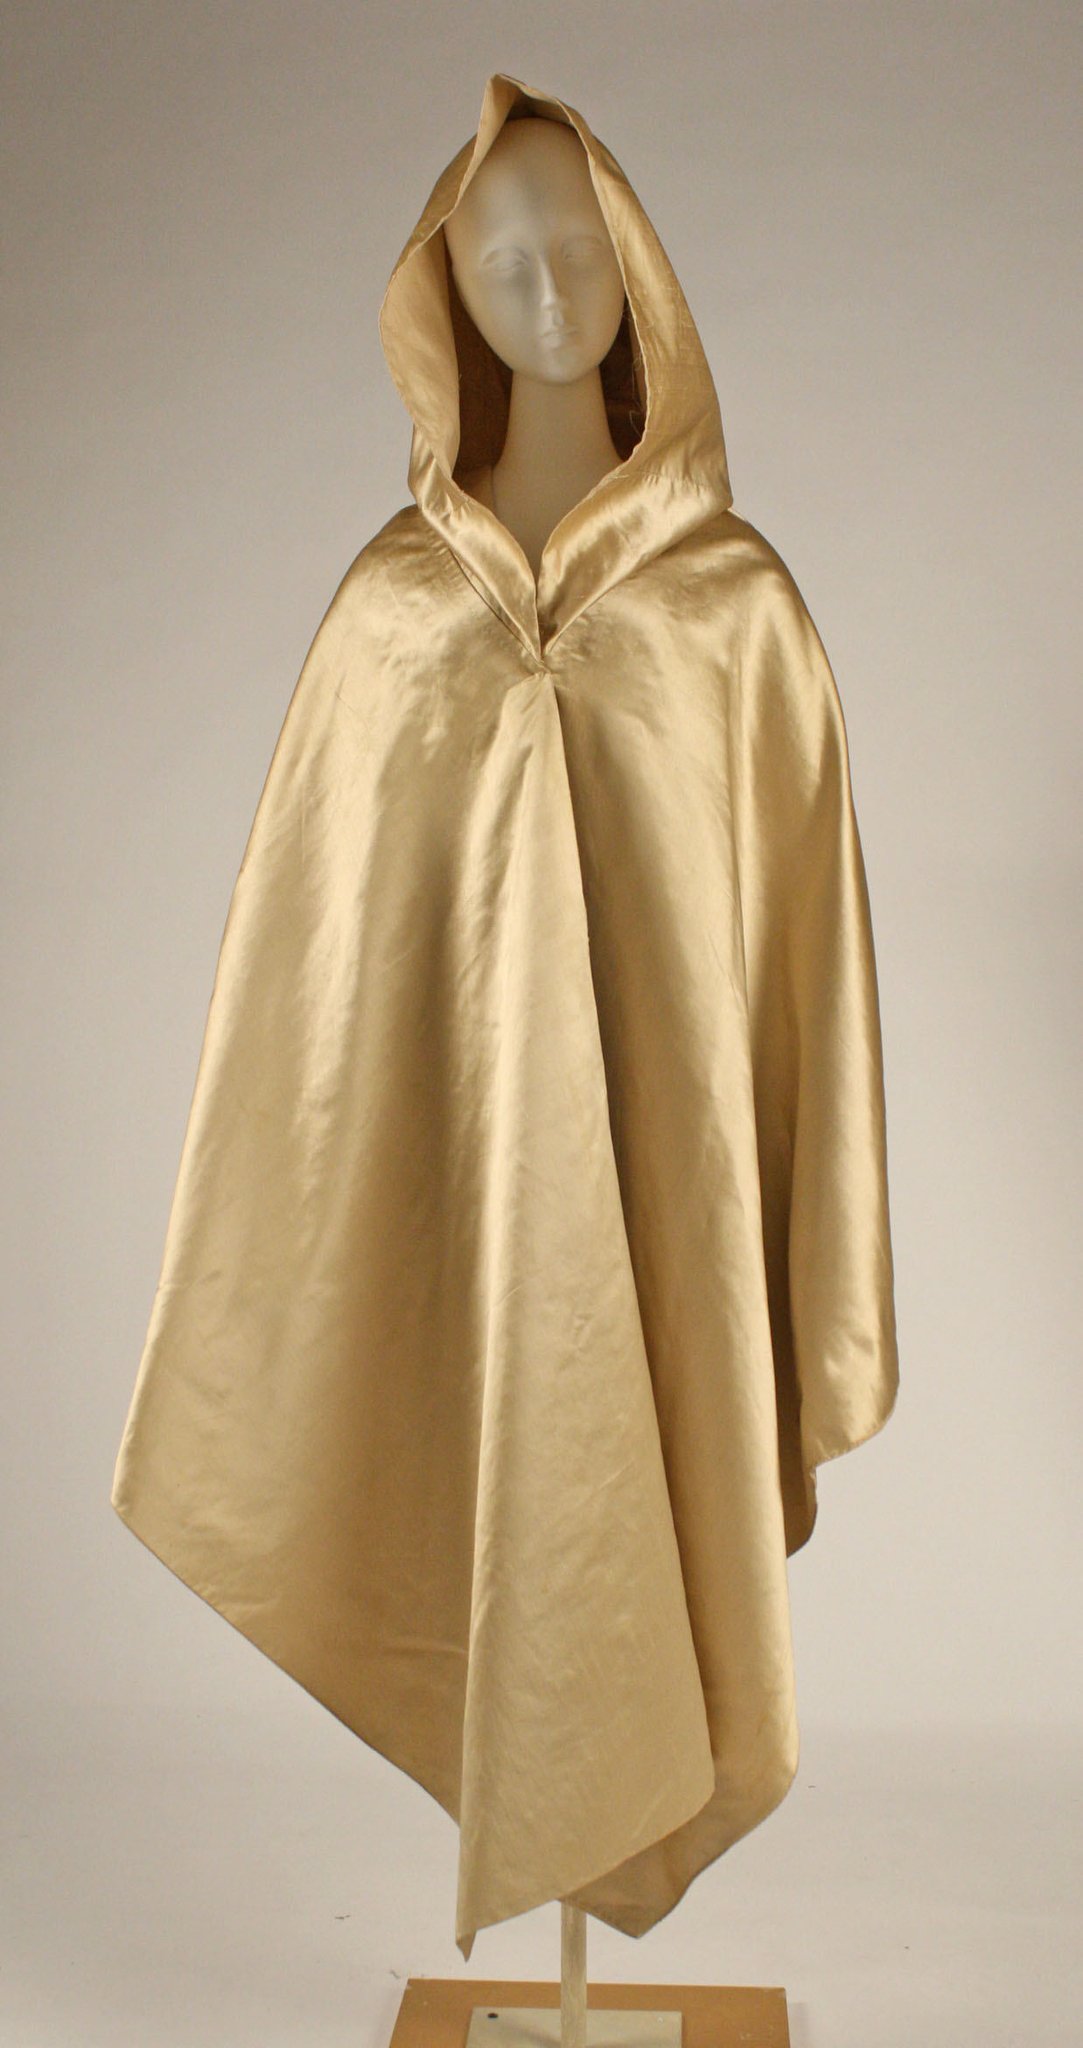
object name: capuchin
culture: american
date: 1810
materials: silk